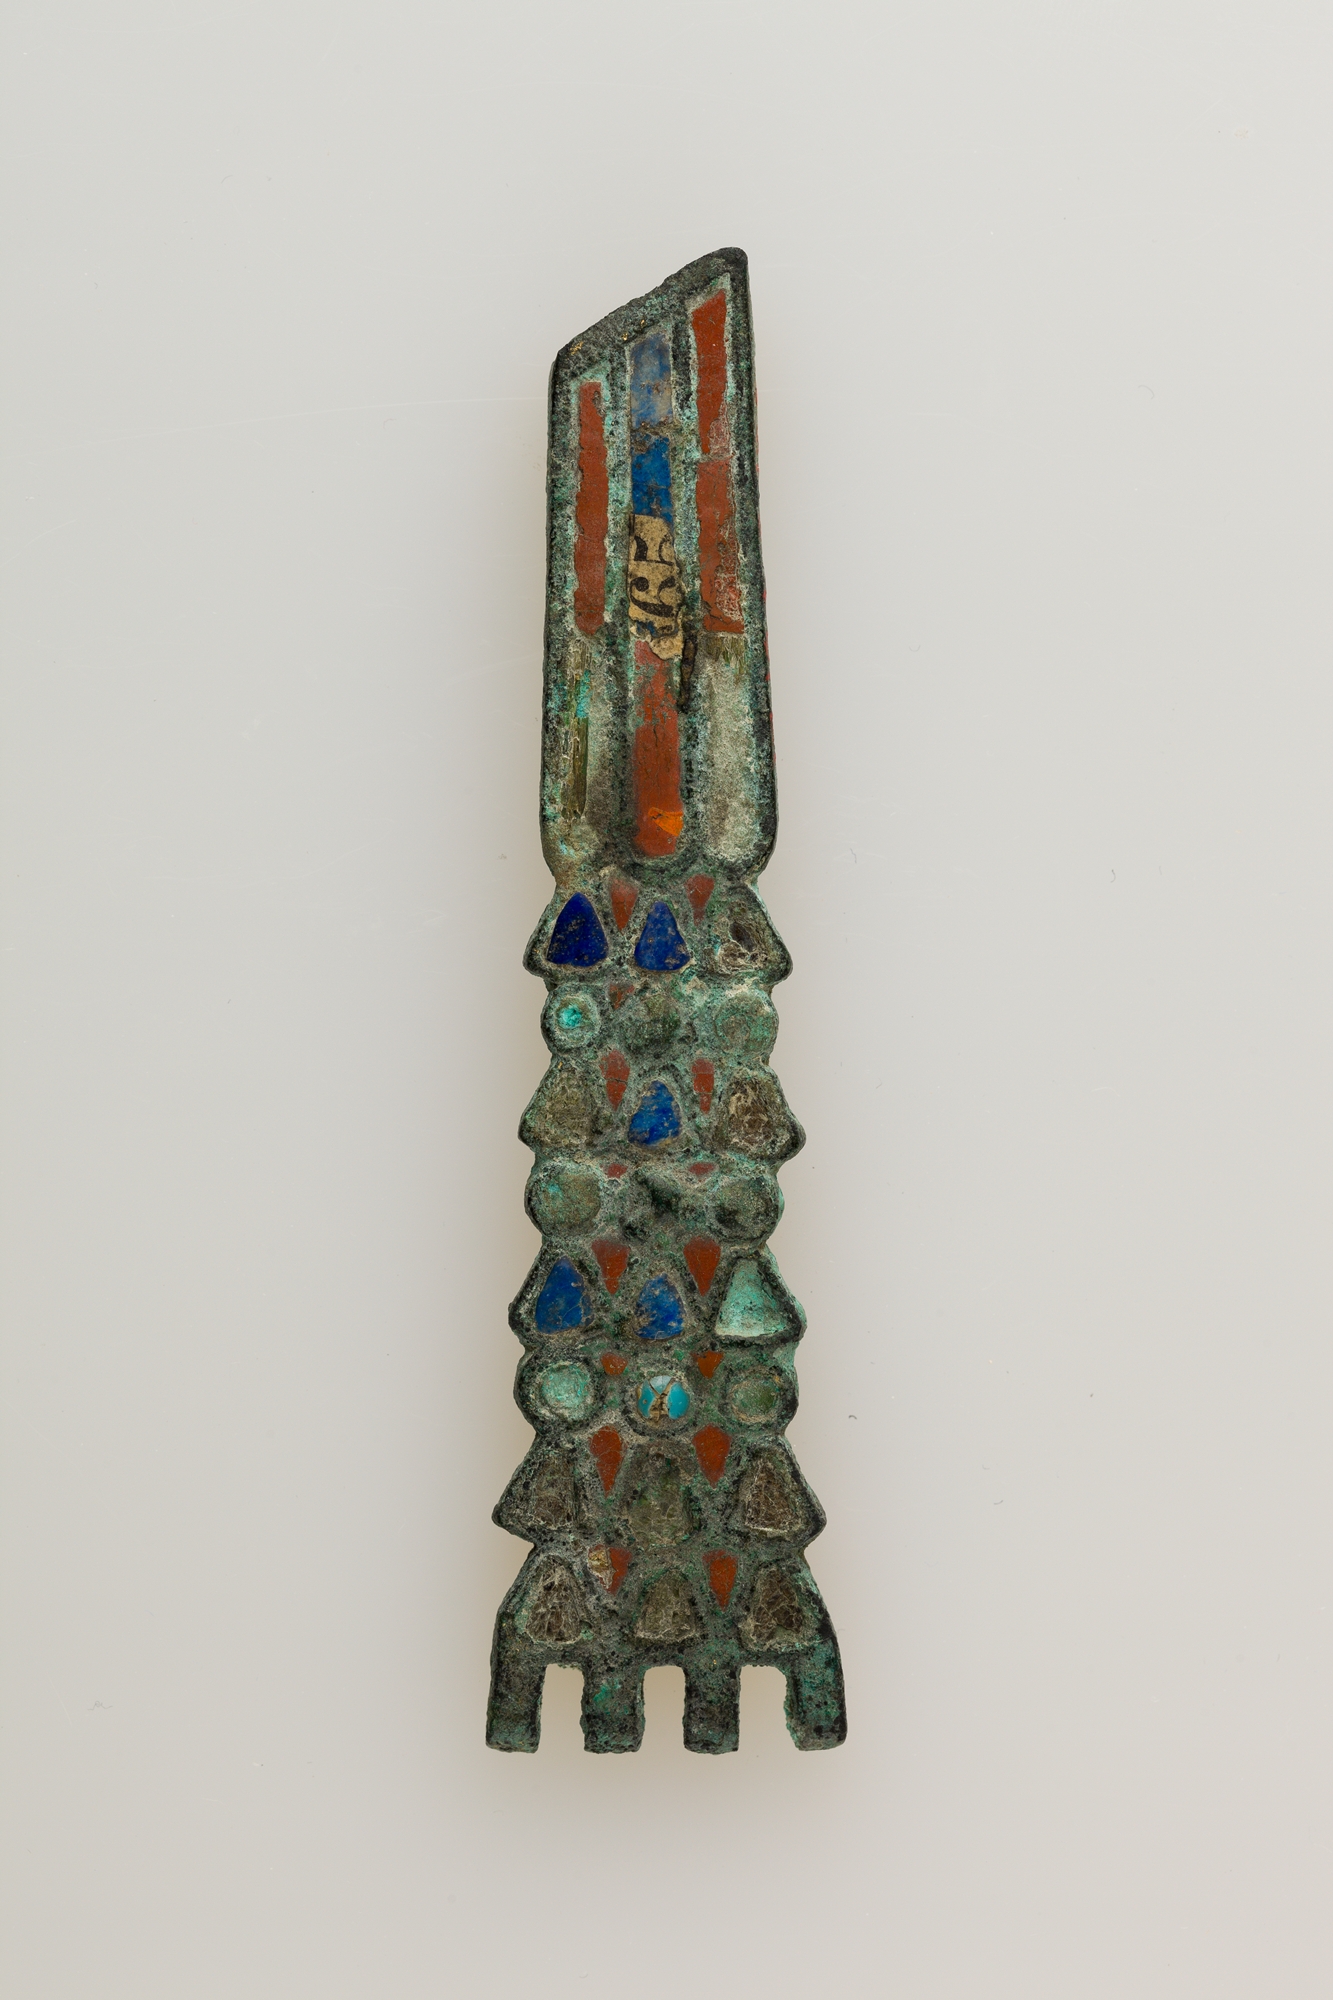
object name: scepter attachment, flail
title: Part of a flail for a statue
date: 664-630 BCE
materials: metal, glass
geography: egypt